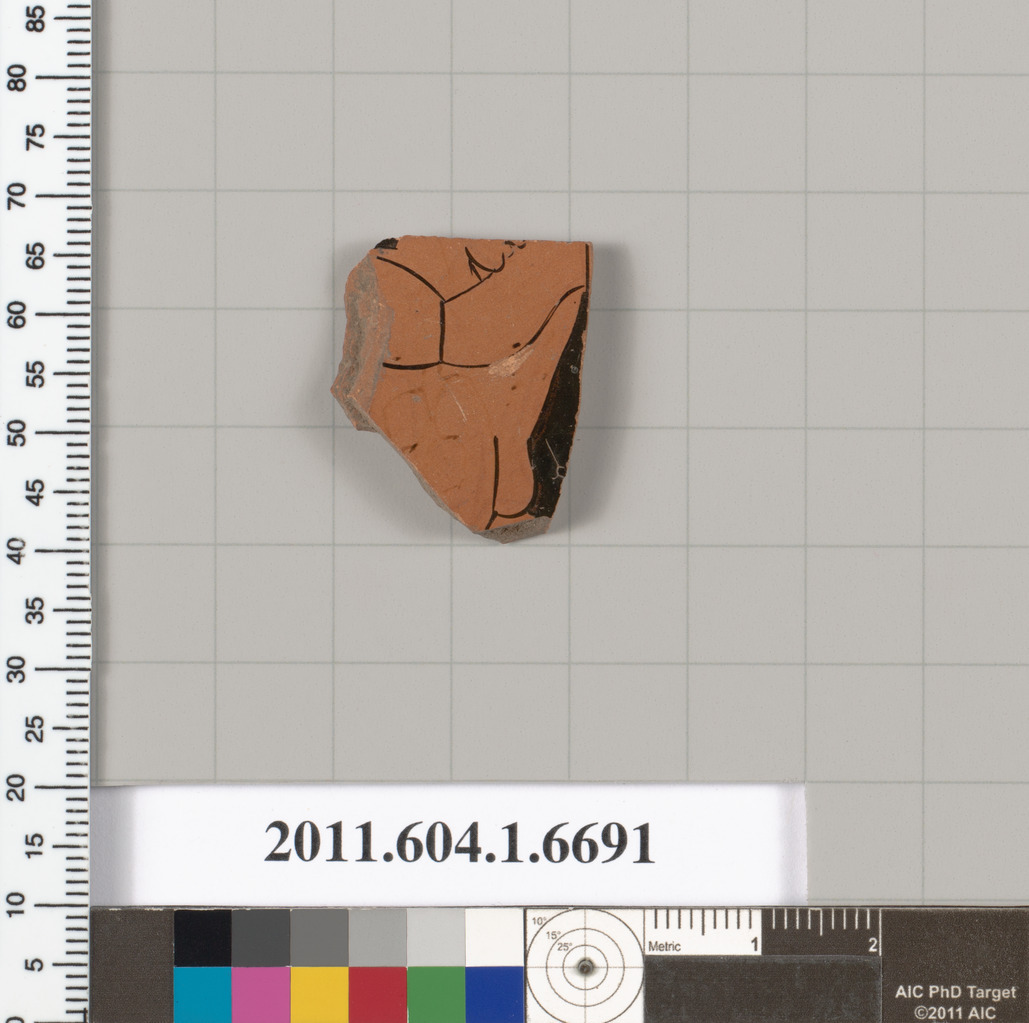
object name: kylix fragment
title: Terracotta fragment of a kylix (drinking cup)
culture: greek, attic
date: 490-470 BCE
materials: terracotta